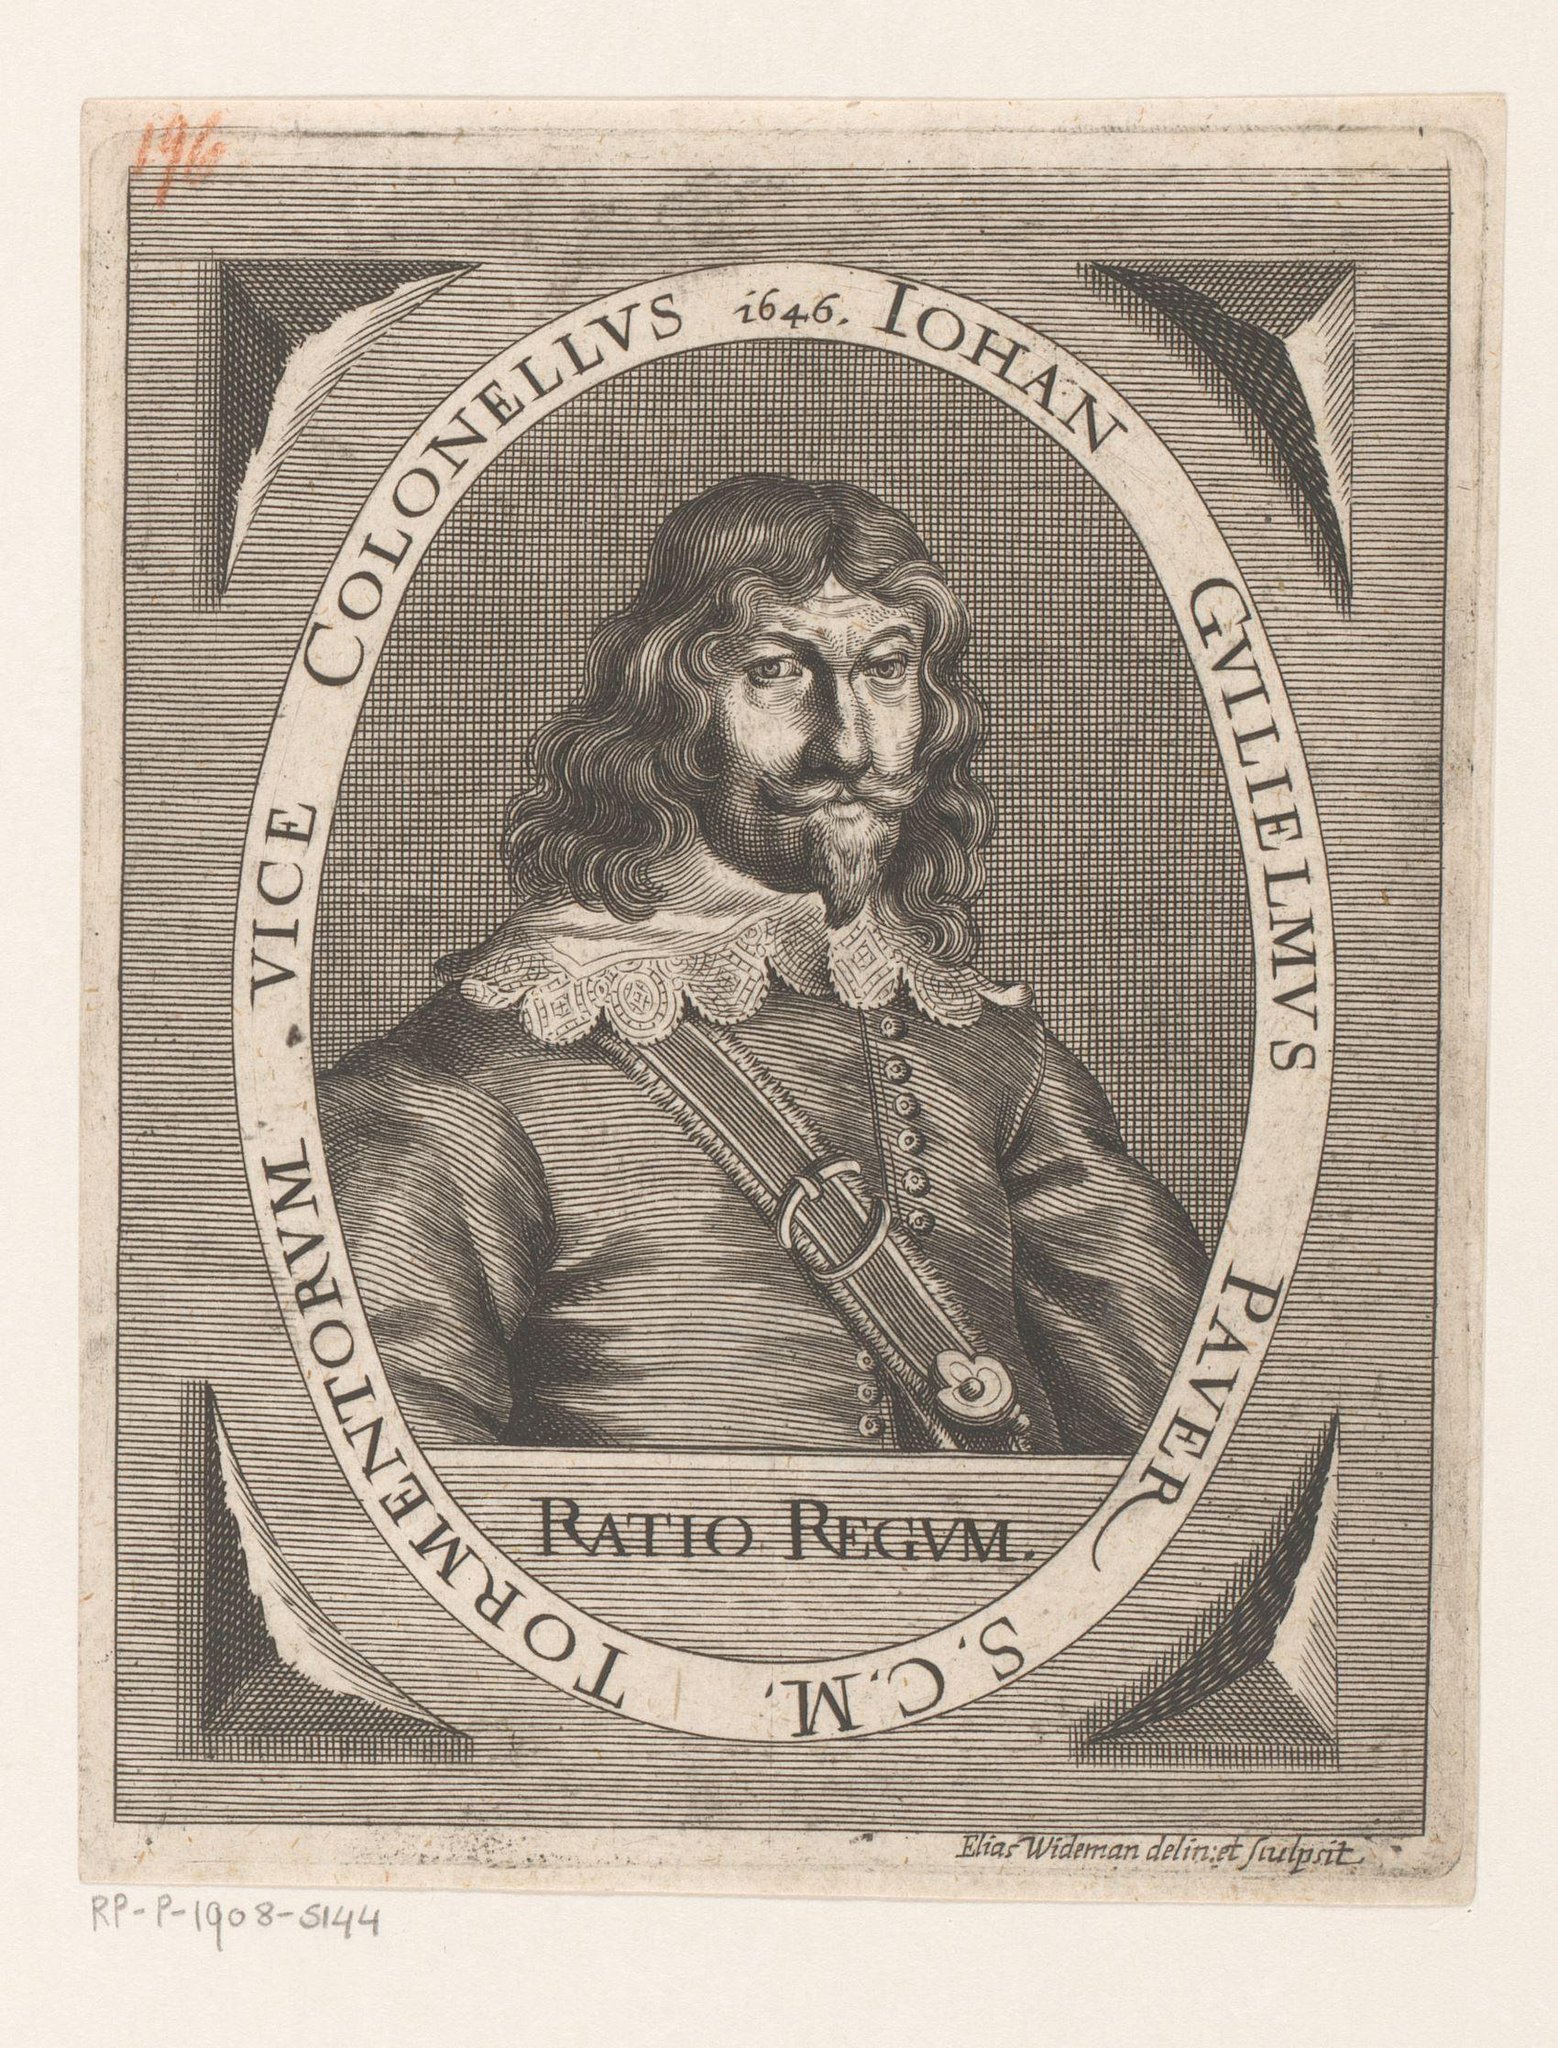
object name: print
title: Gaspar Johann Wilhelm Paver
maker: elias widemann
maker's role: print maker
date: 1646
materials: paper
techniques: engraving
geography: vienna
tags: historical persons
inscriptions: inscription: ‘S’, collector's mark: Lugt 2228, number: ‘No 1376.’